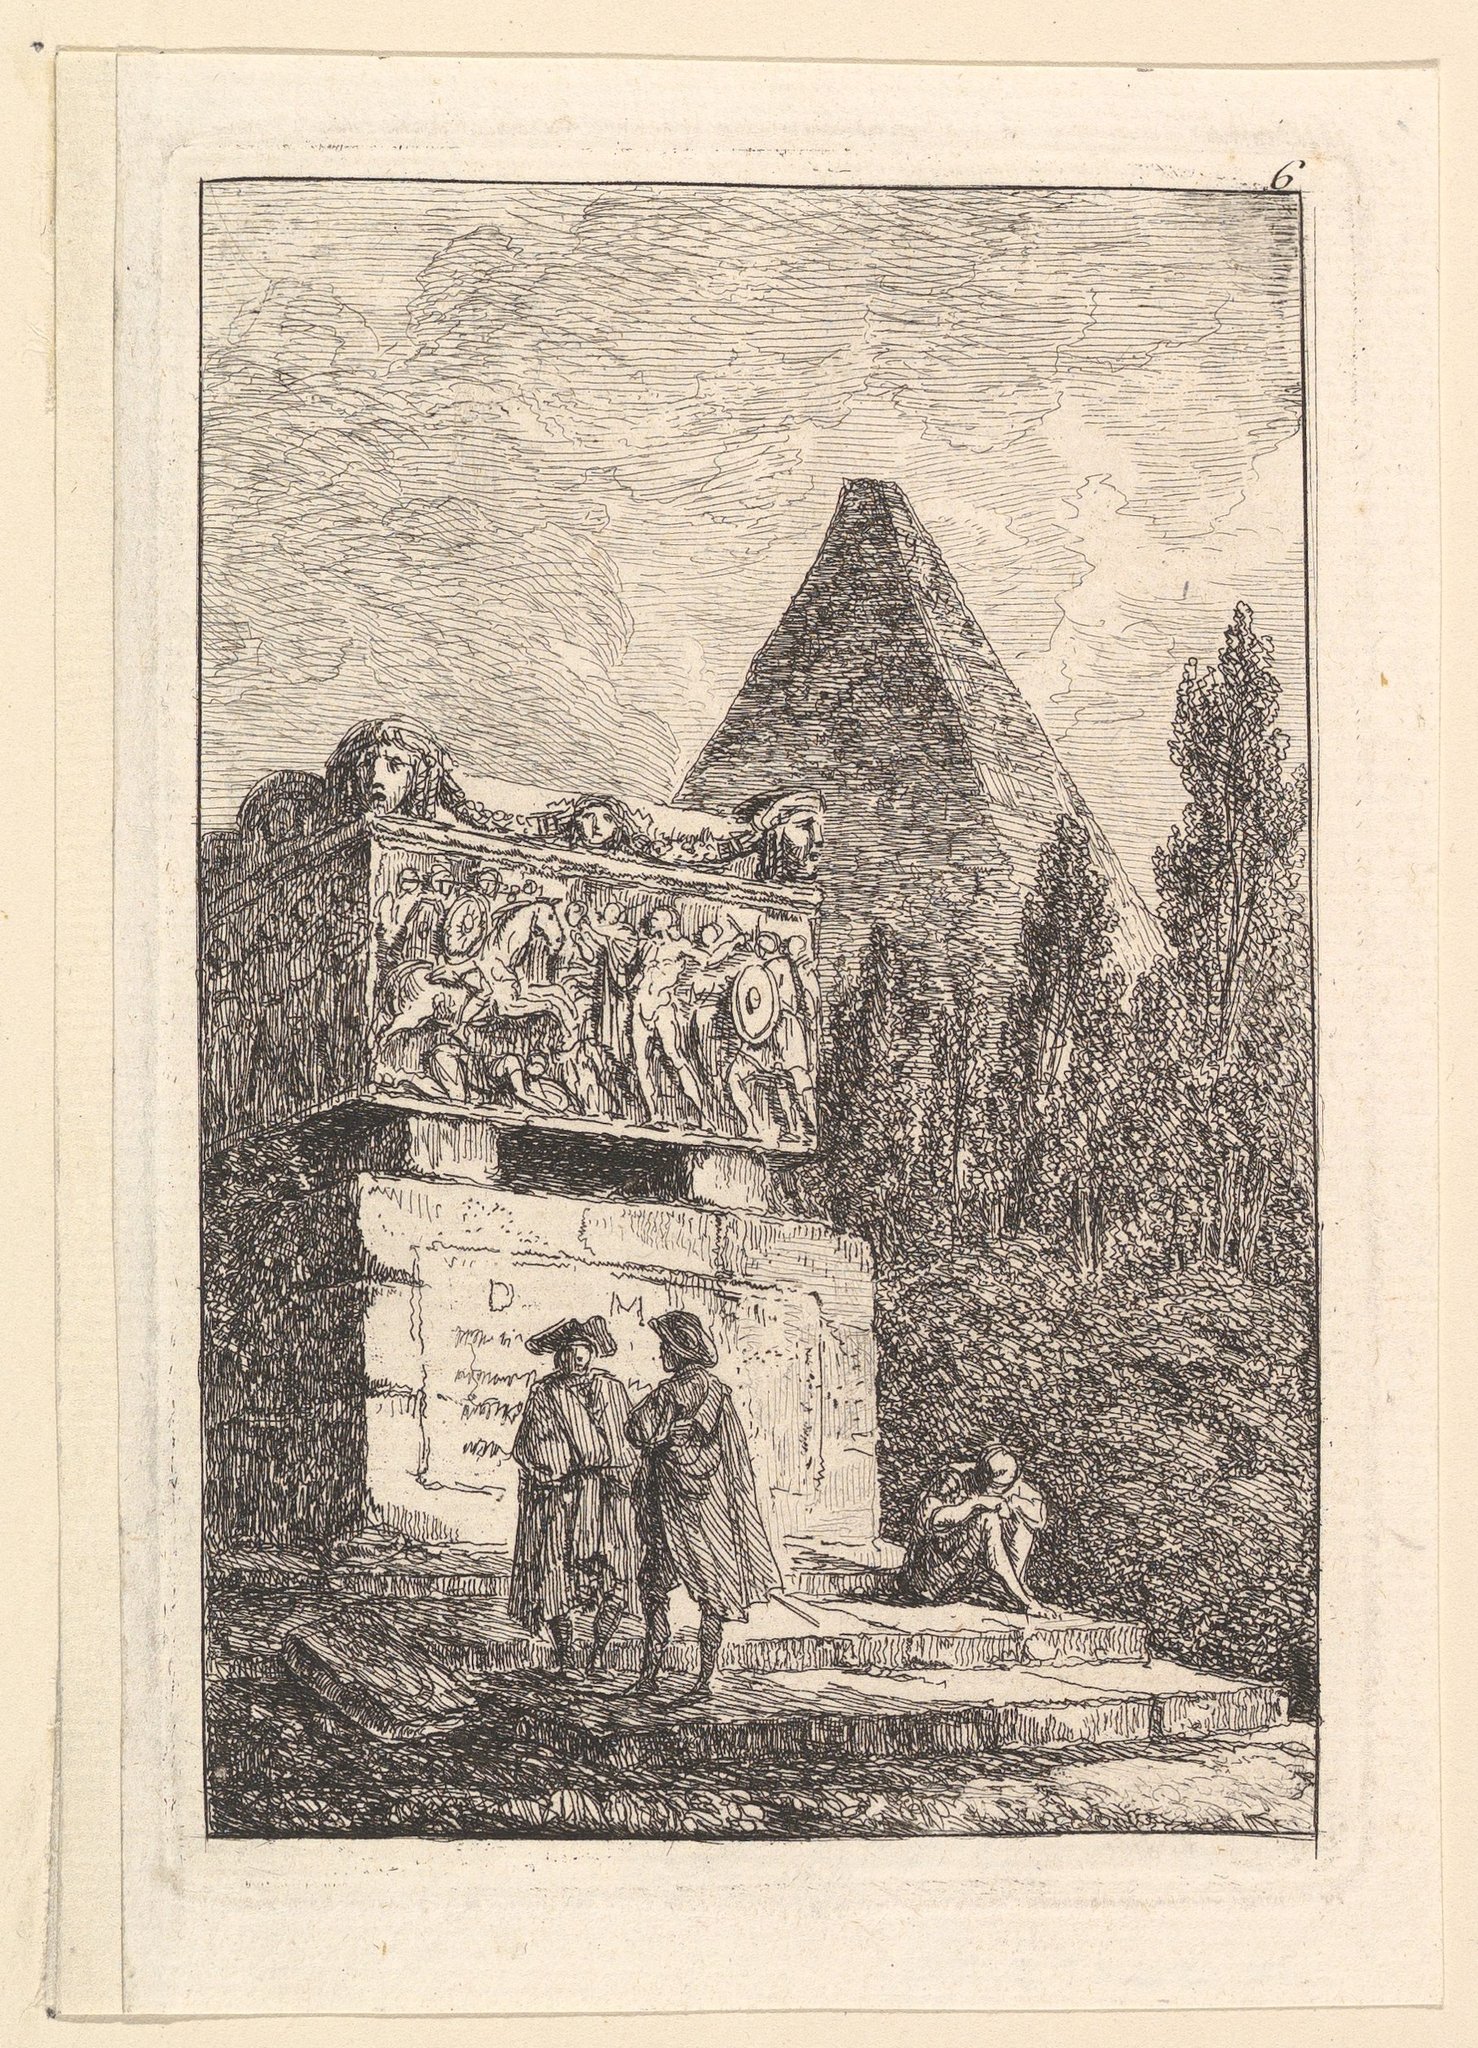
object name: print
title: Le Sarcophage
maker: hubert robert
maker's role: artist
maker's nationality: french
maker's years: 1733-1808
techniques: etching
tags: sarcophagus